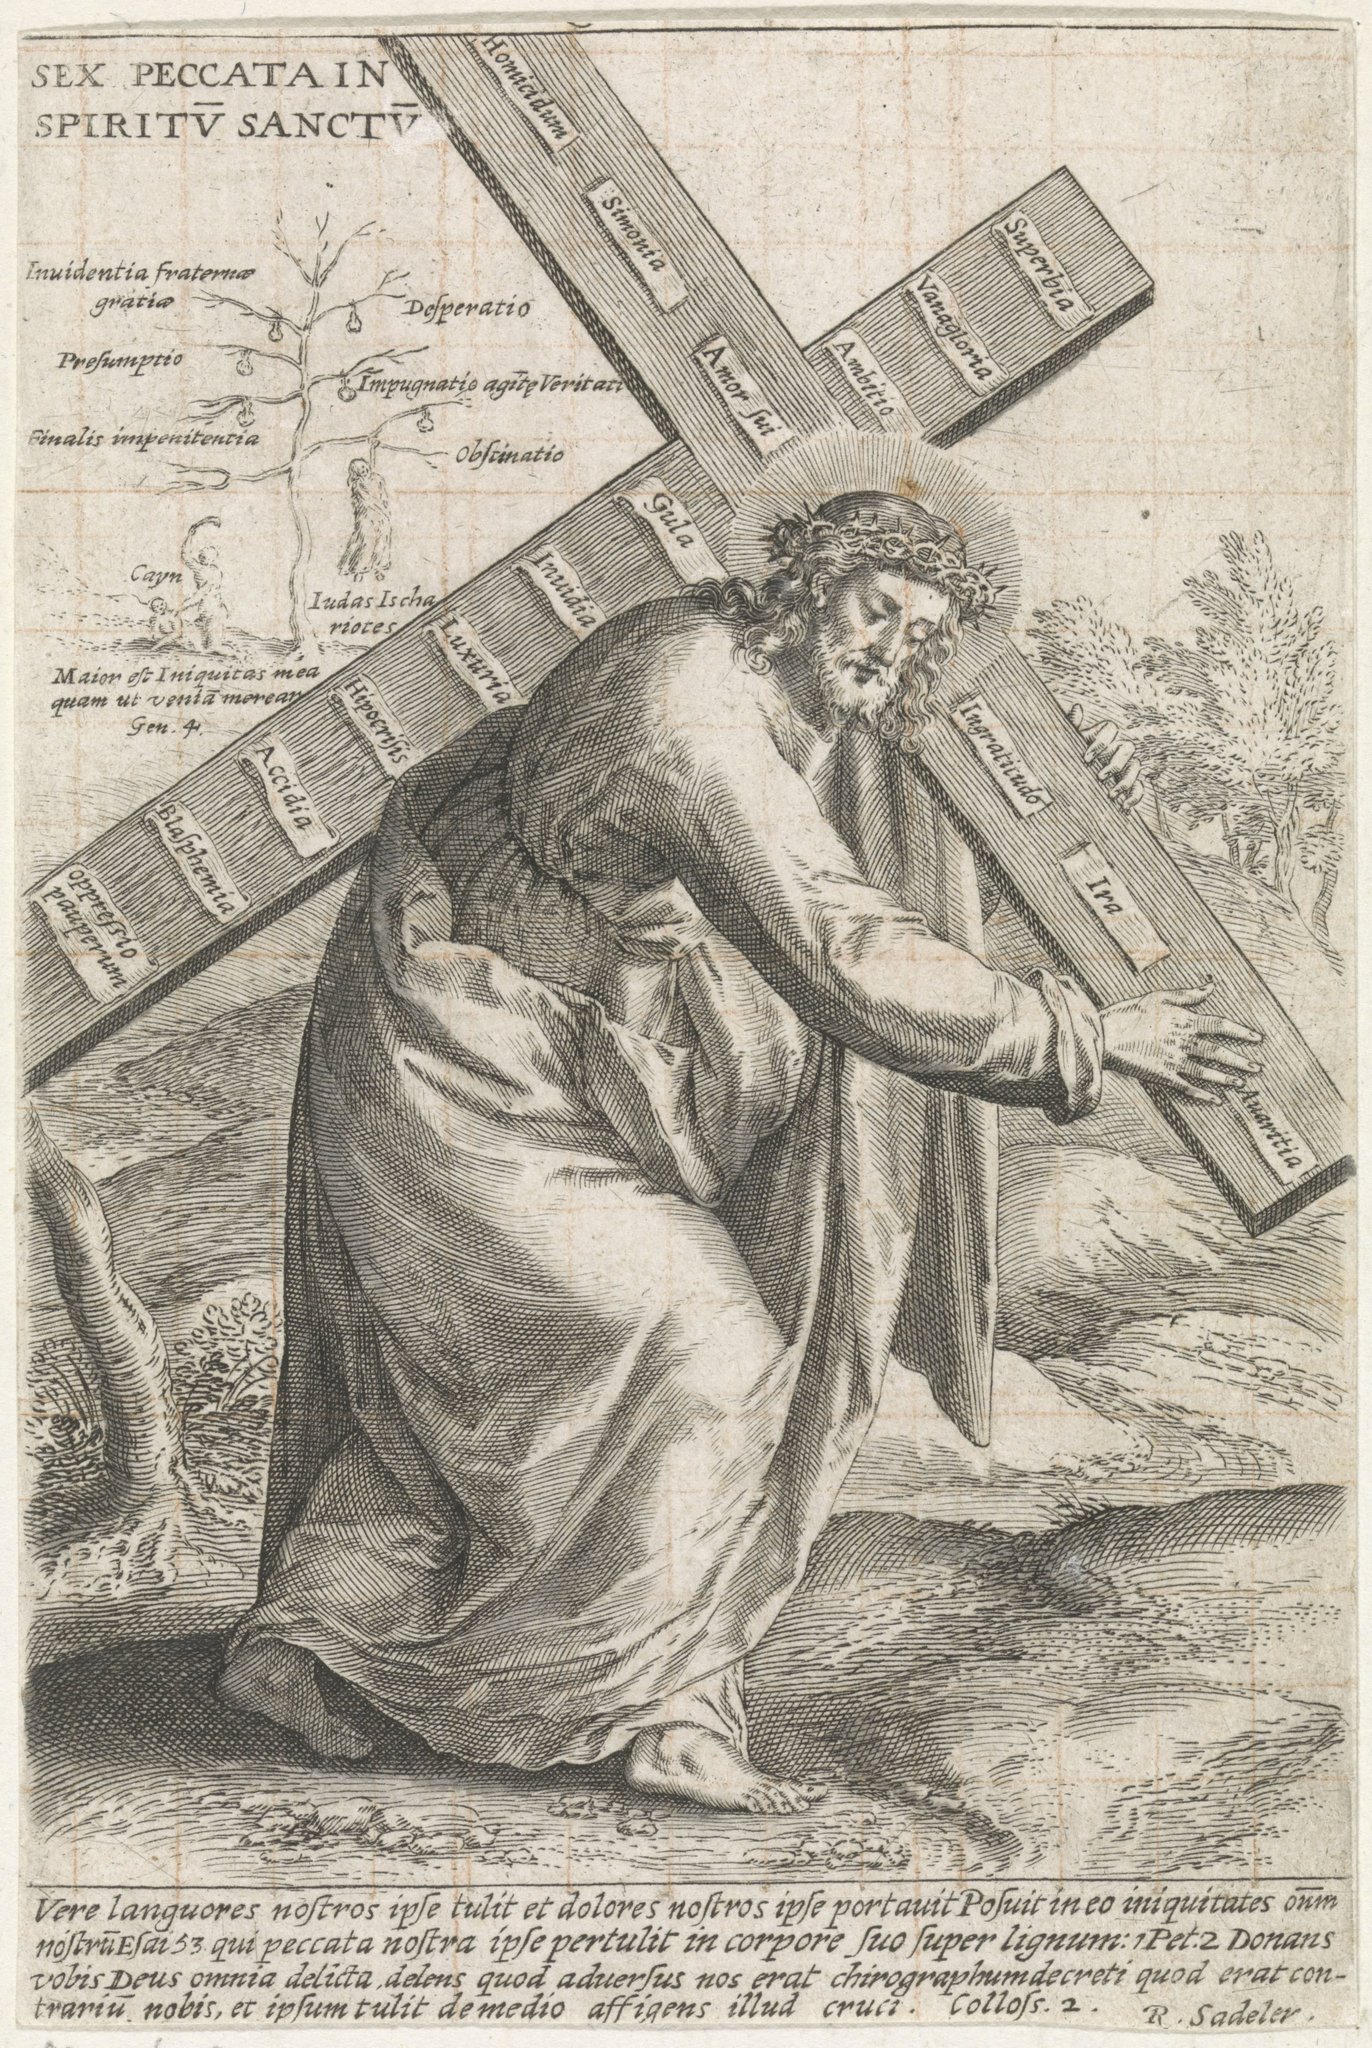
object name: print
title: Christus draagt het kruis met de zonden van de wereld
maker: maerten de vos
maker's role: draughtsman, painter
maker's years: 1532-1603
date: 1560-1632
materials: paper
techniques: engraving, etching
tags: the killing of abel: cain slays him with a stone, a club or a jaw-bone, alternatively with a spade or another tool as weapon, judas hanging himself, the tree of knowledge of good and evil (whose fruit, usually apples or figs, brings death); the tree may be guarded by the serpent, carrying of the cross: christ bearing the cross, alone or with the help of others (e.g. simon the cyrenian), doctrine on original sin, and redemption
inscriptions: collector's mark: Lugt 2228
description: Christus met het kruis op weg naar Golgotha. Op het kruis zestien zonden in het Latijn. Op de achtergrond de moord op Abel door Caïn, de boom van de kennis van goed en kwaad en de zelfmoord van Judas. De prent heeft een Latijns onderschrift.